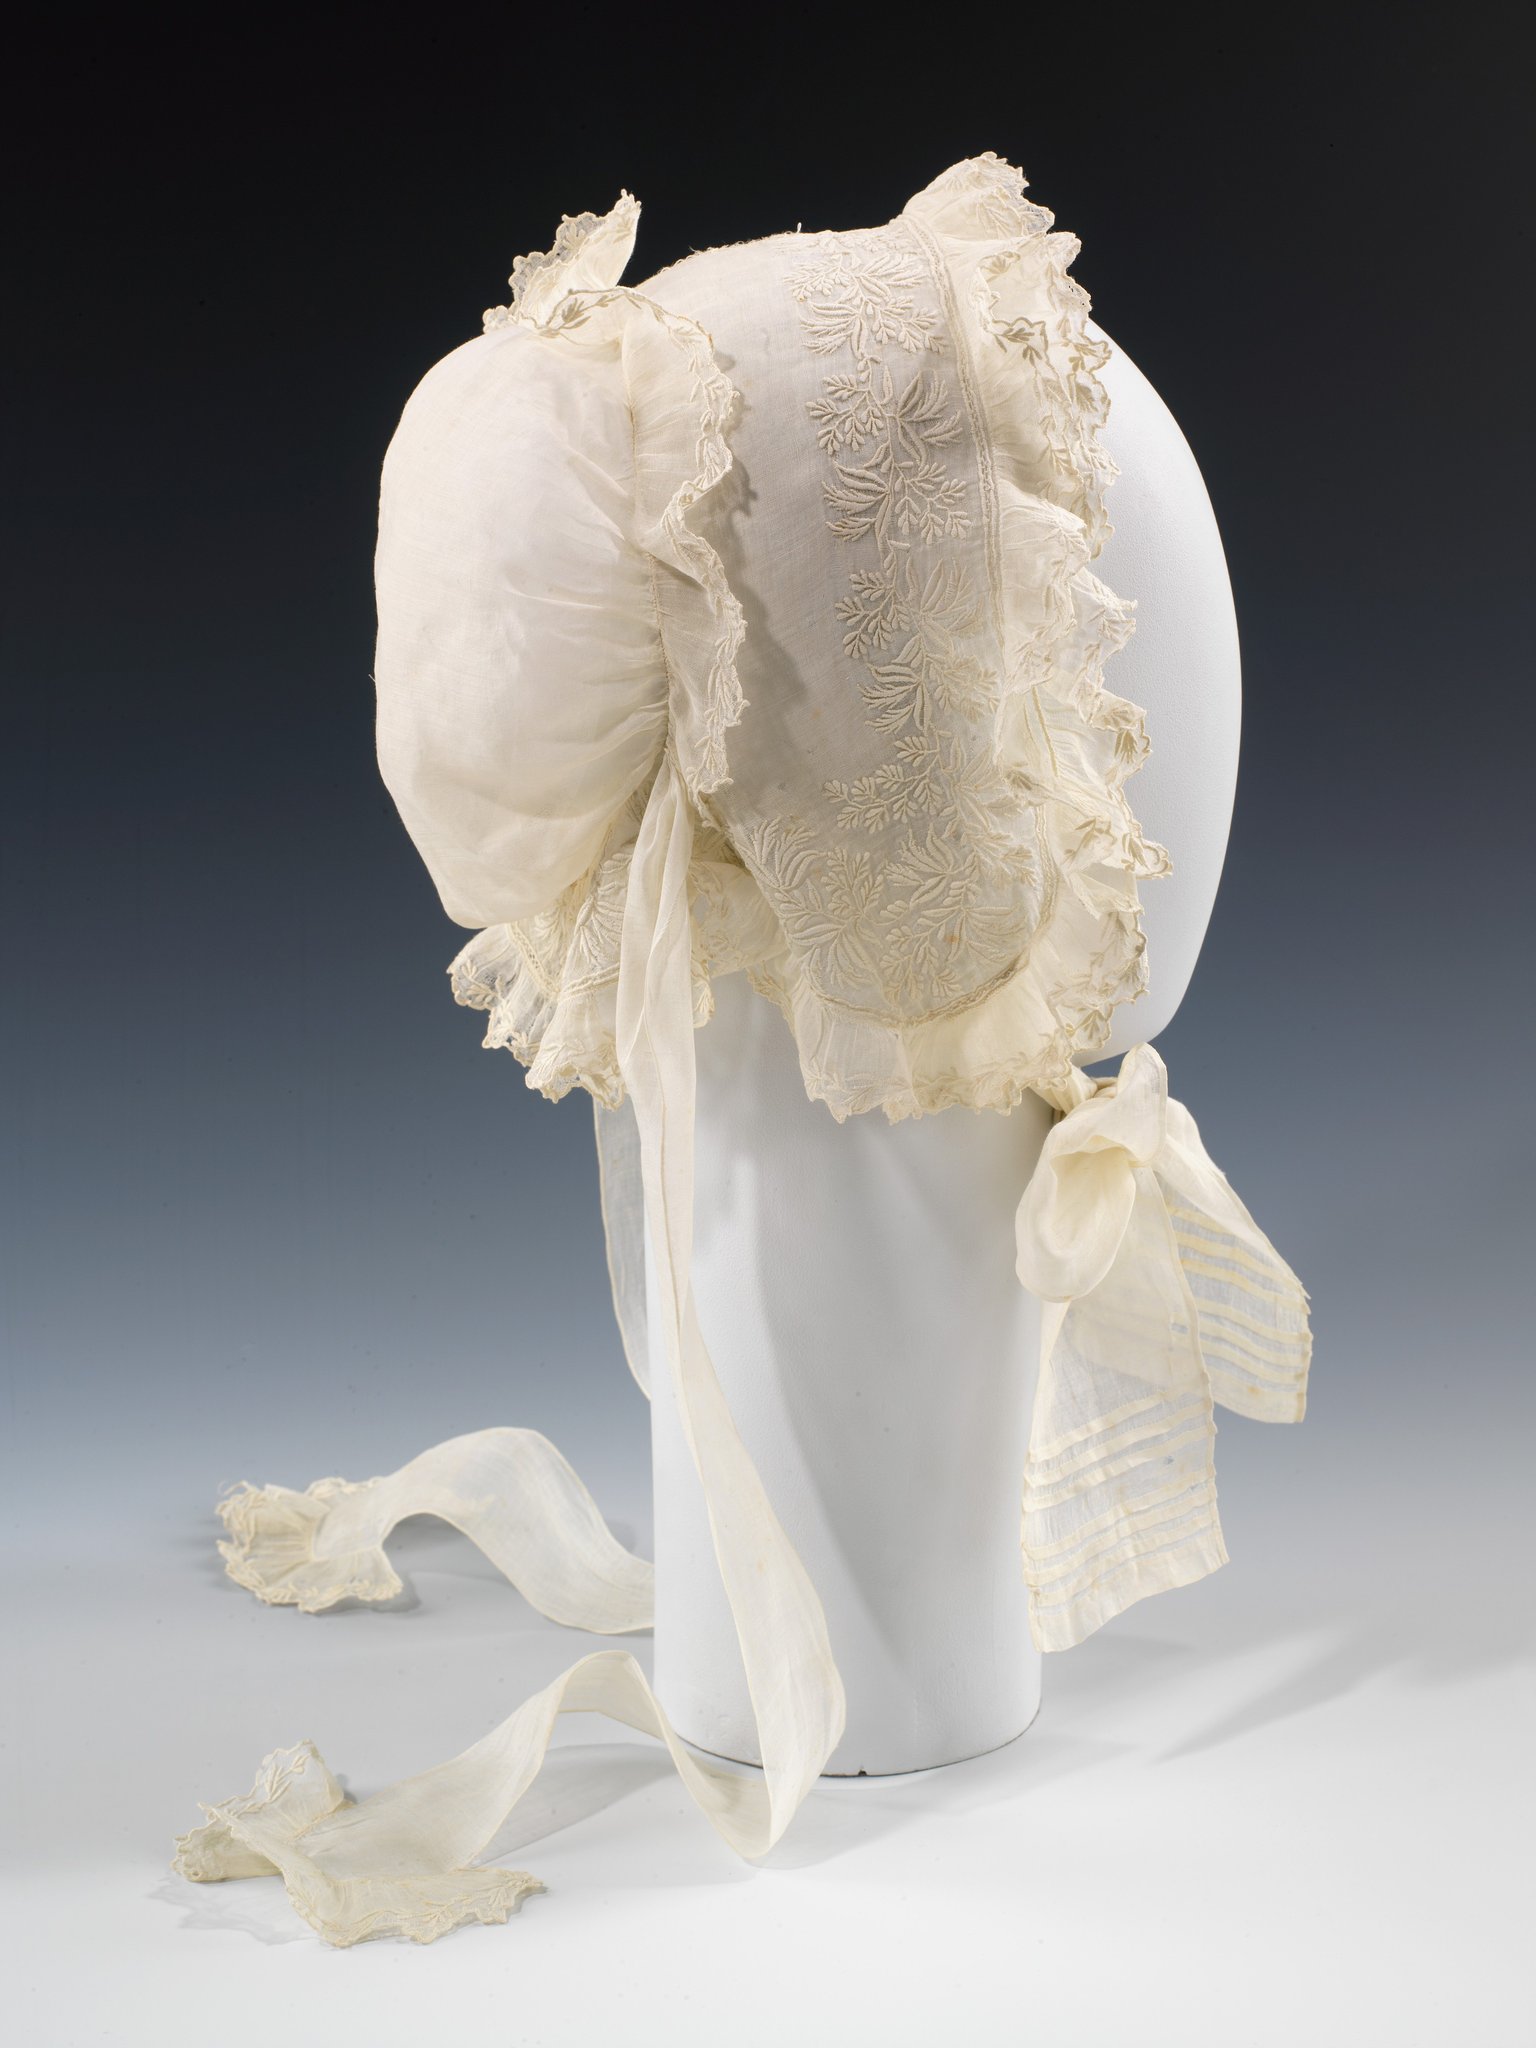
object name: morning cap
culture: american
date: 1837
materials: cotton